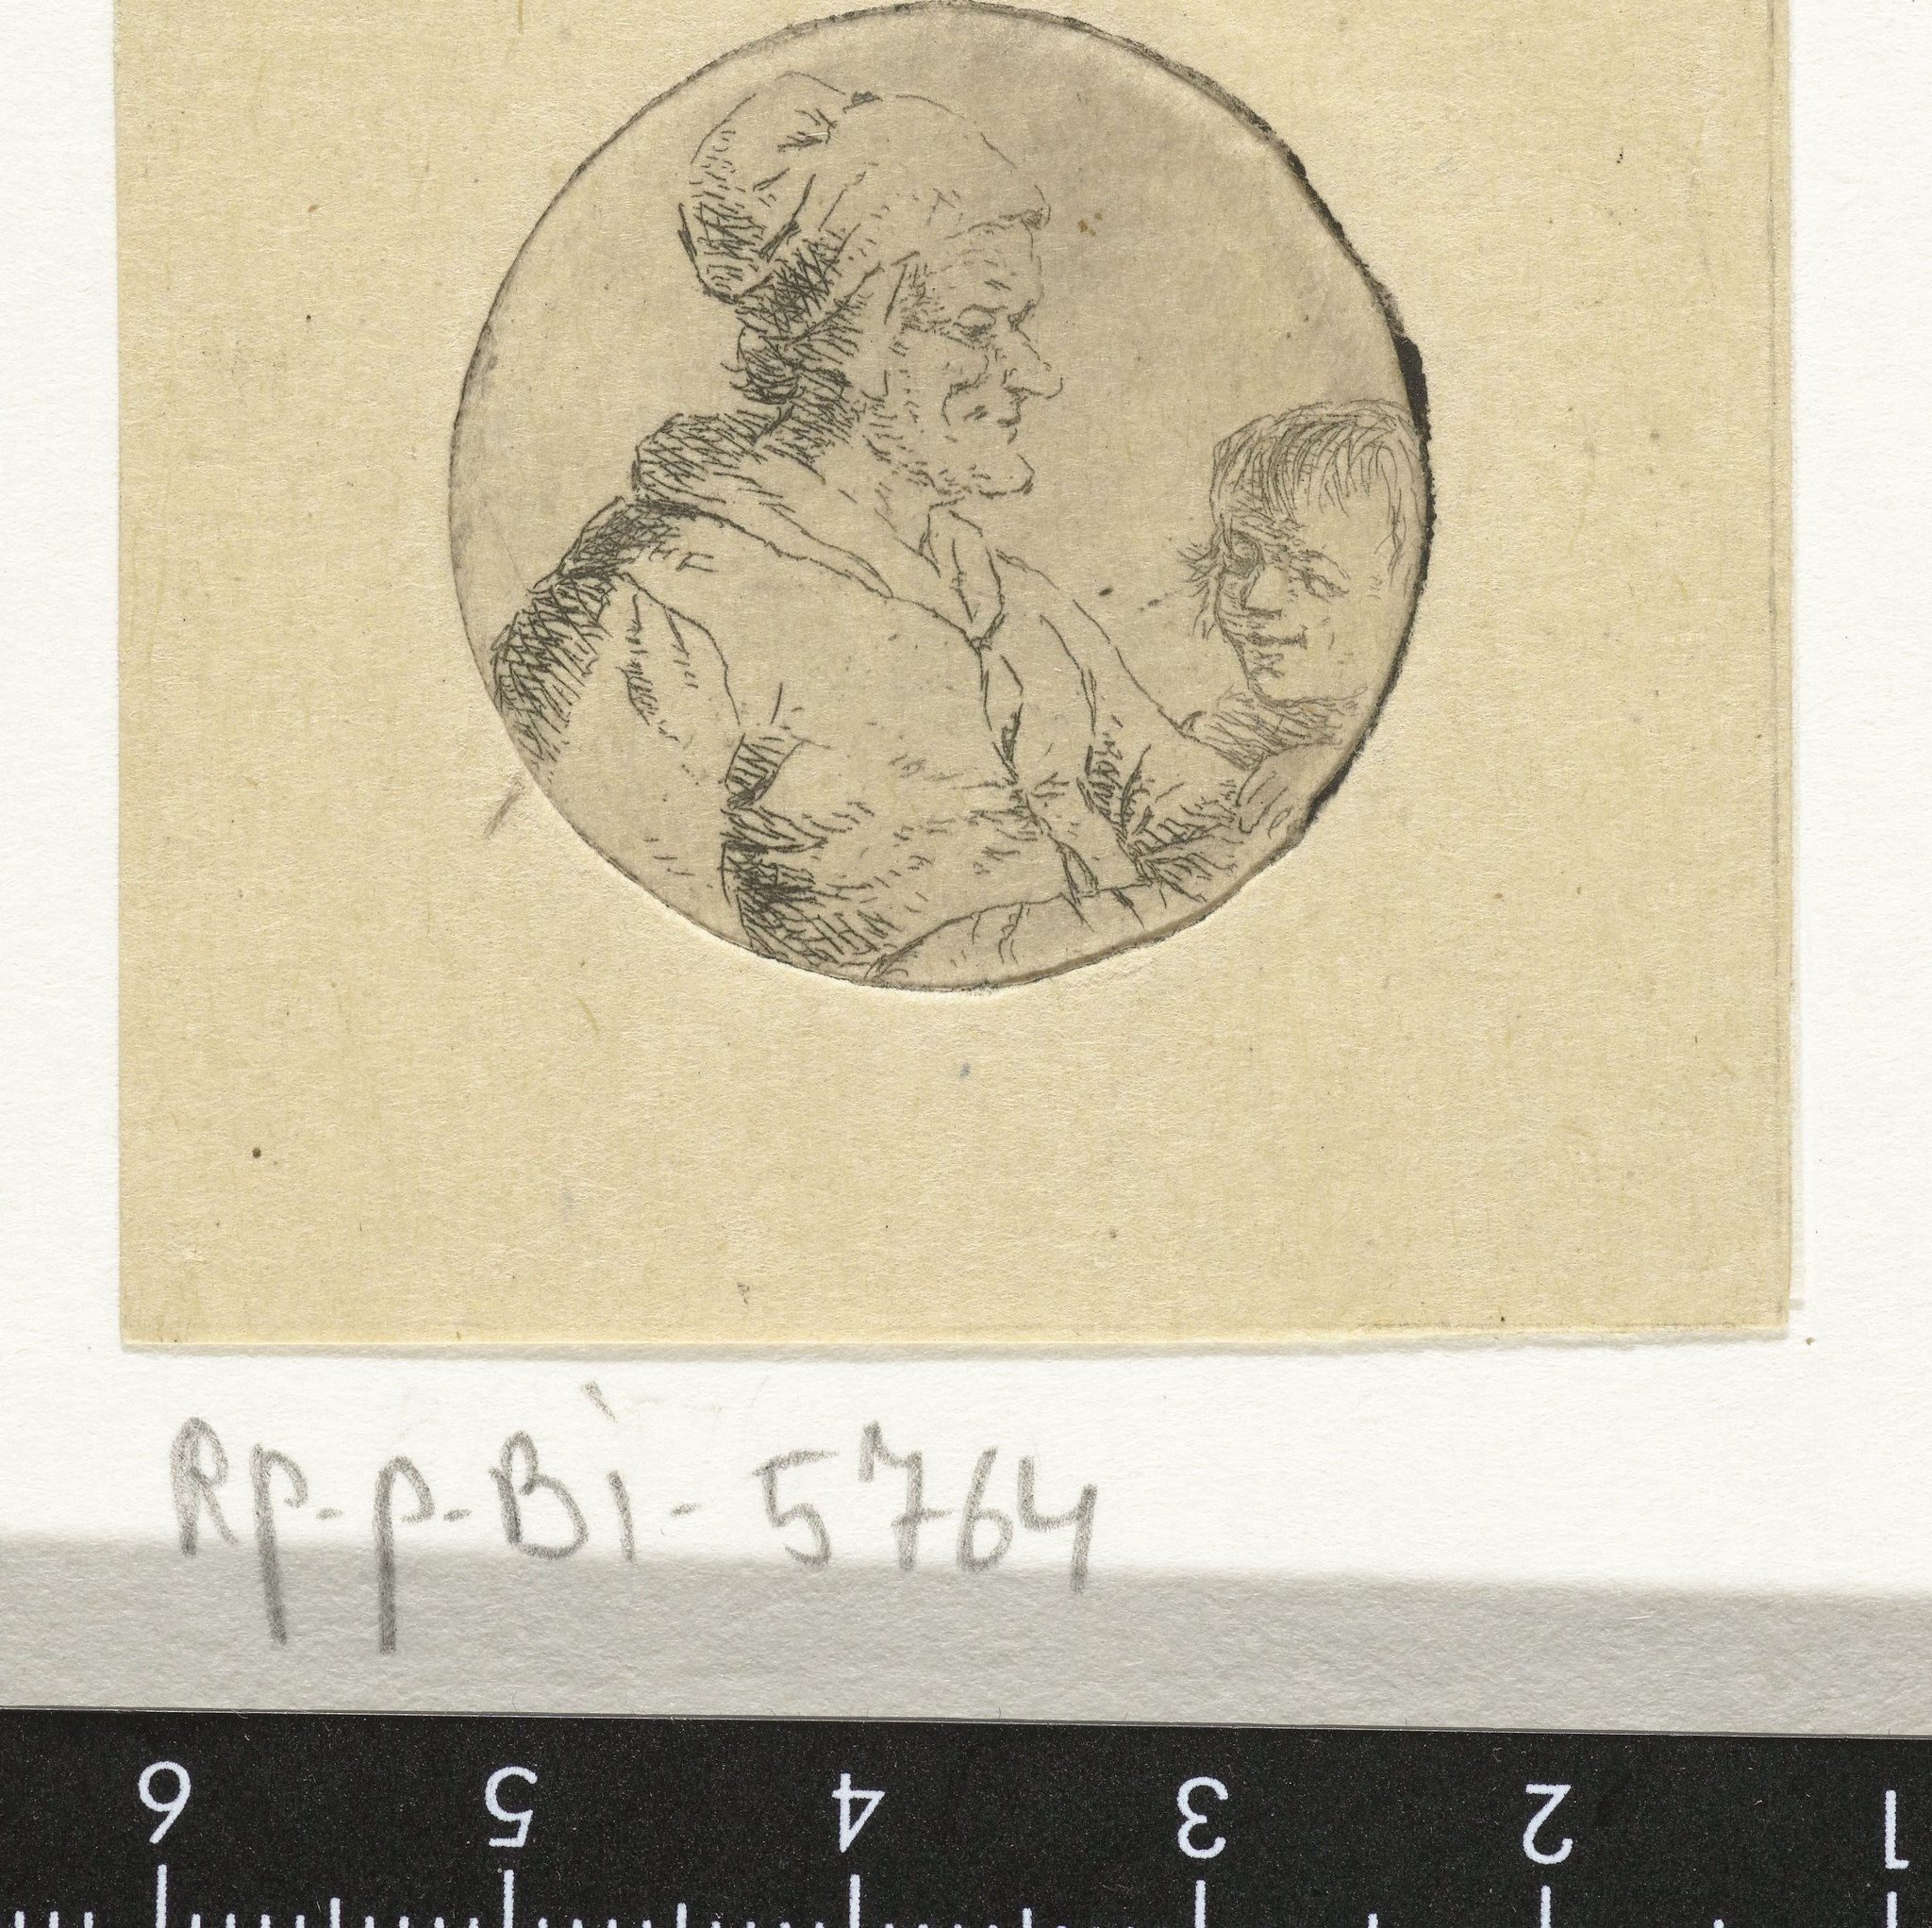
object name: print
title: Buste van een onbekende man met kind (versie 1)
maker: christina chalon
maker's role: draughtsman, print maker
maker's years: 1748-1808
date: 1758-1808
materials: paper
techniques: etching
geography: leiden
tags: historical persons (portraits and scenes from the life) (+ profile portrait), father and child(ren), man and child(ren) (family group) (with number of children)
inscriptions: collector's mark: Lugt 2228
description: In een ronde lijst, de buste van een onbekende volwassen man. Buste naar rechts. Naast hem een kind. Buste naar links.